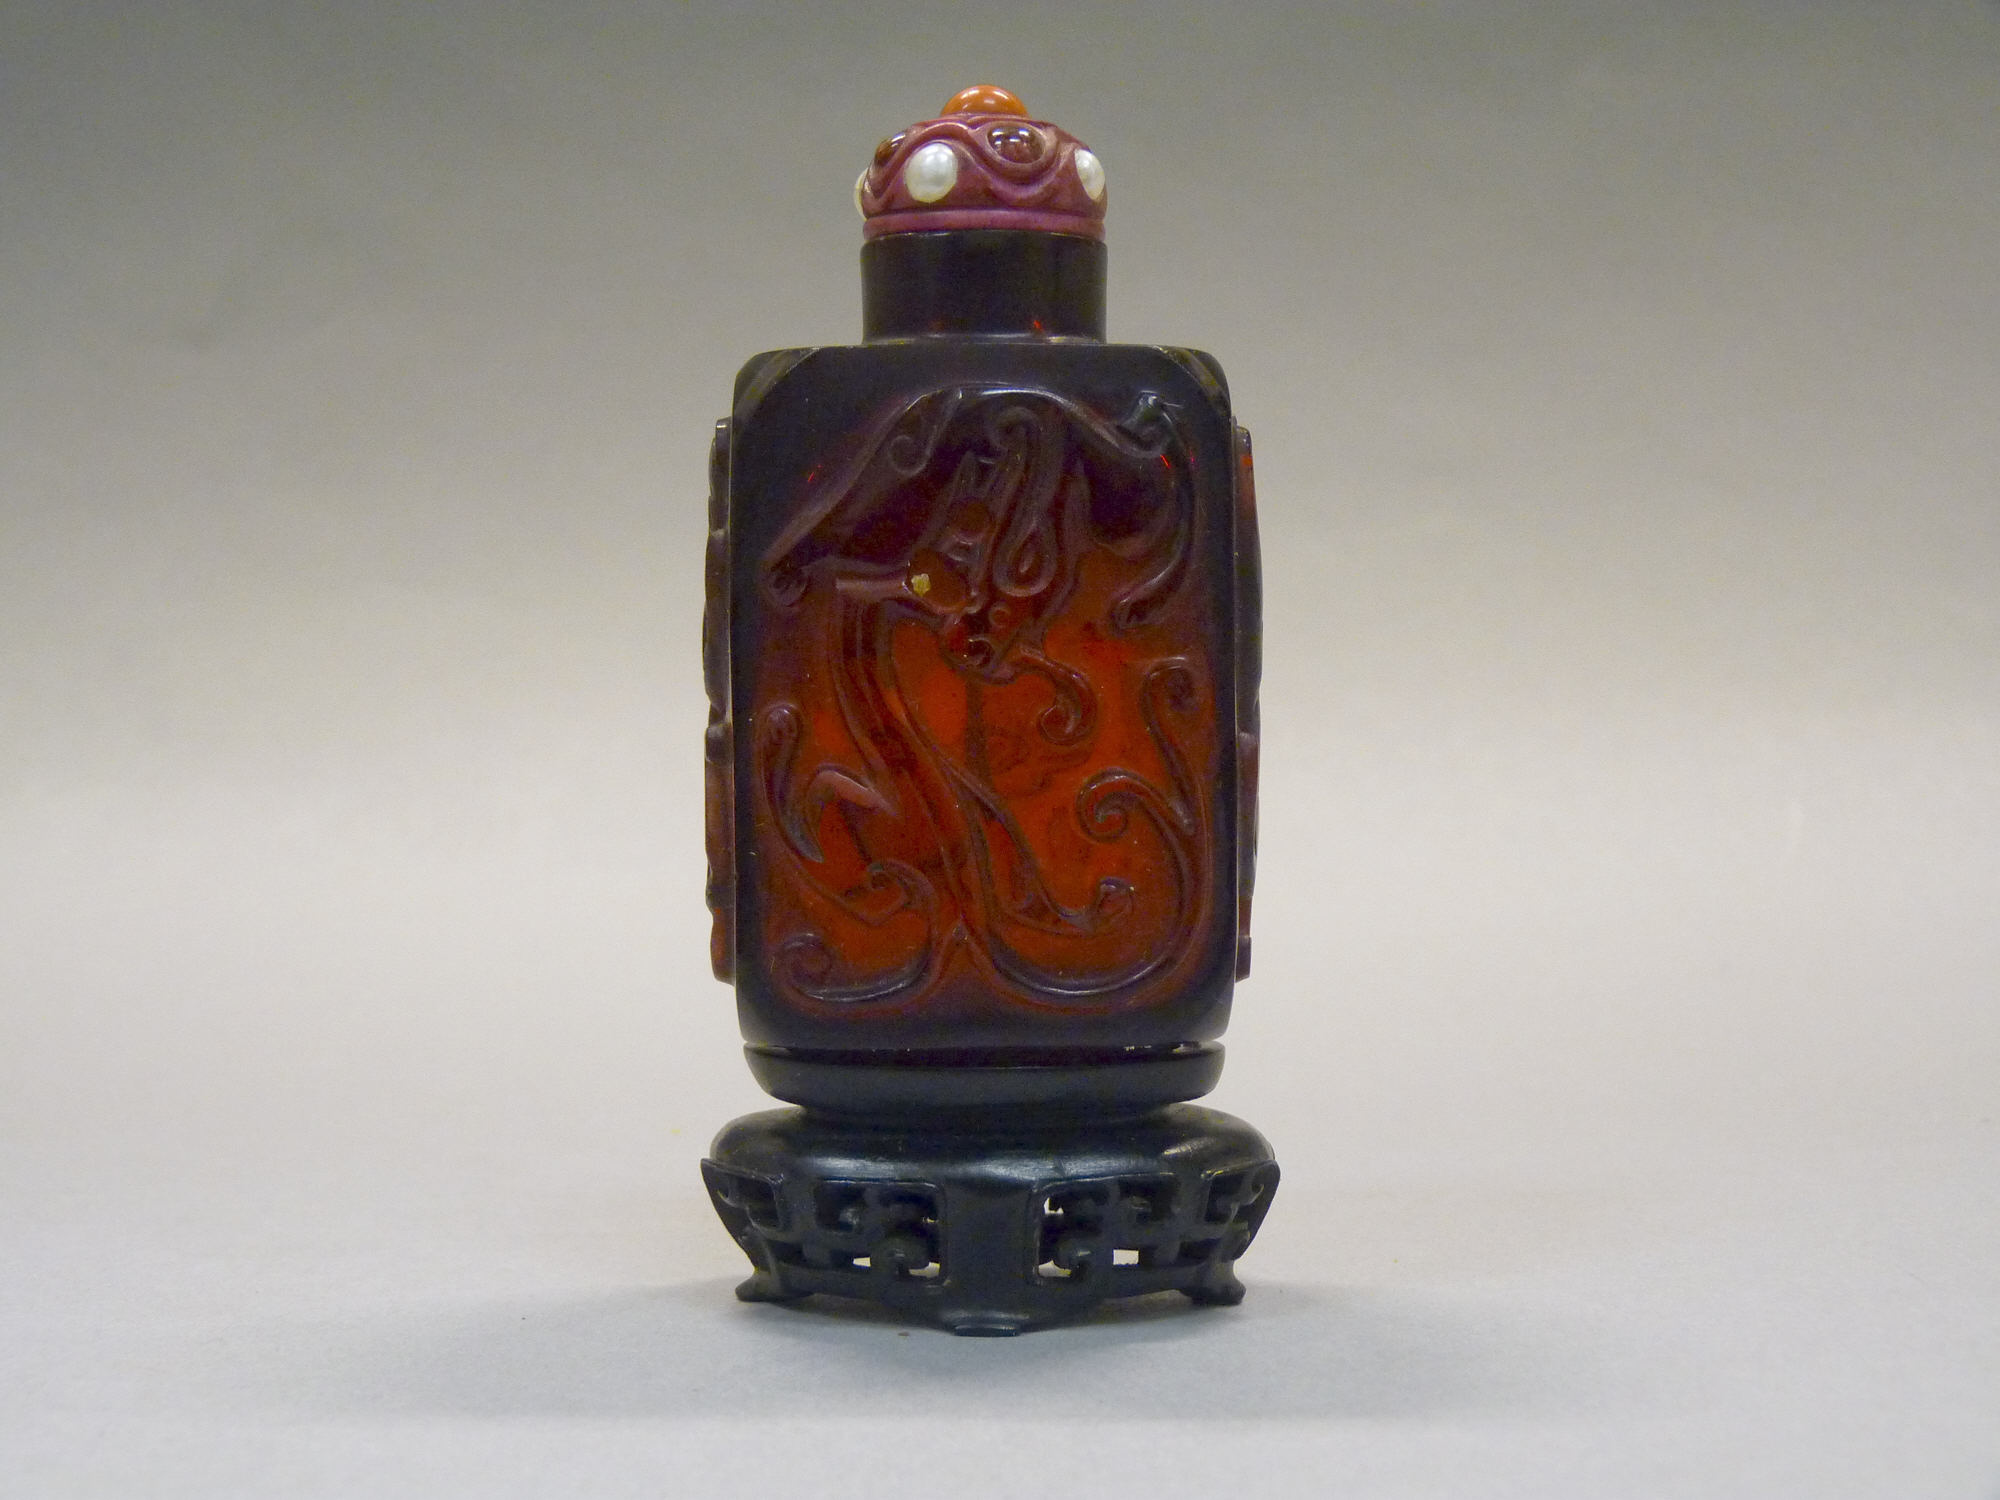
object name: snuff bottle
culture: chinese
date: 1736-1795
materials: glass